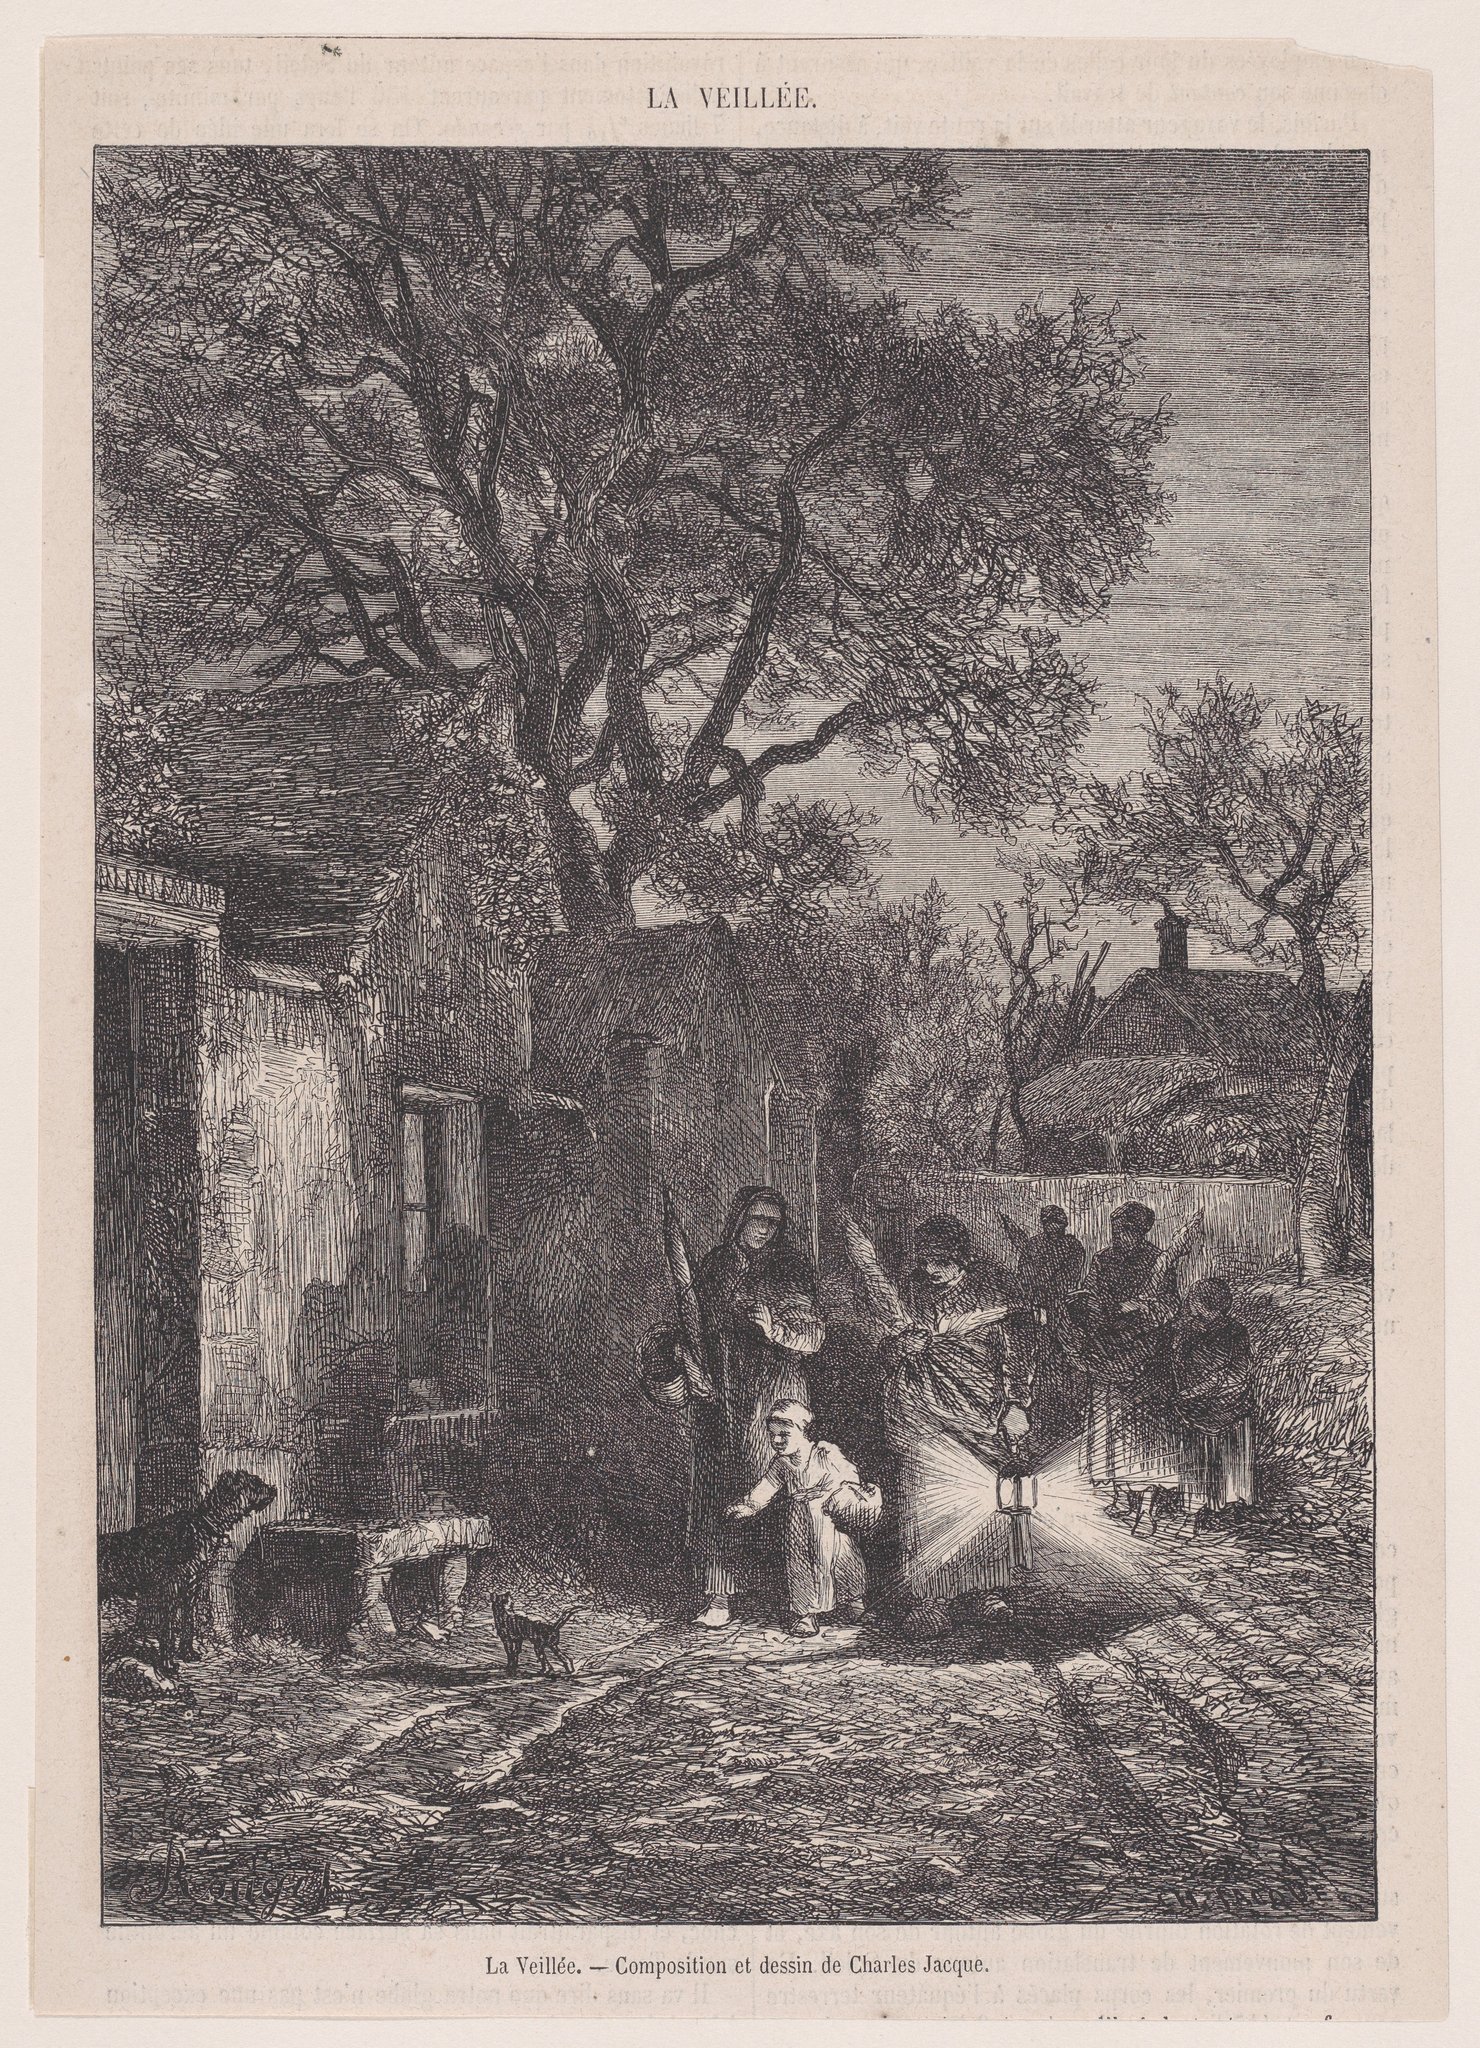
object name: print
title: La Veillée, from "Le Magasin Pittoresque"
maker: charles émile jacque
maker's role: artist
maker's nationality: french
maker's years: 1813-1894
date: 1852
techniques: engraving